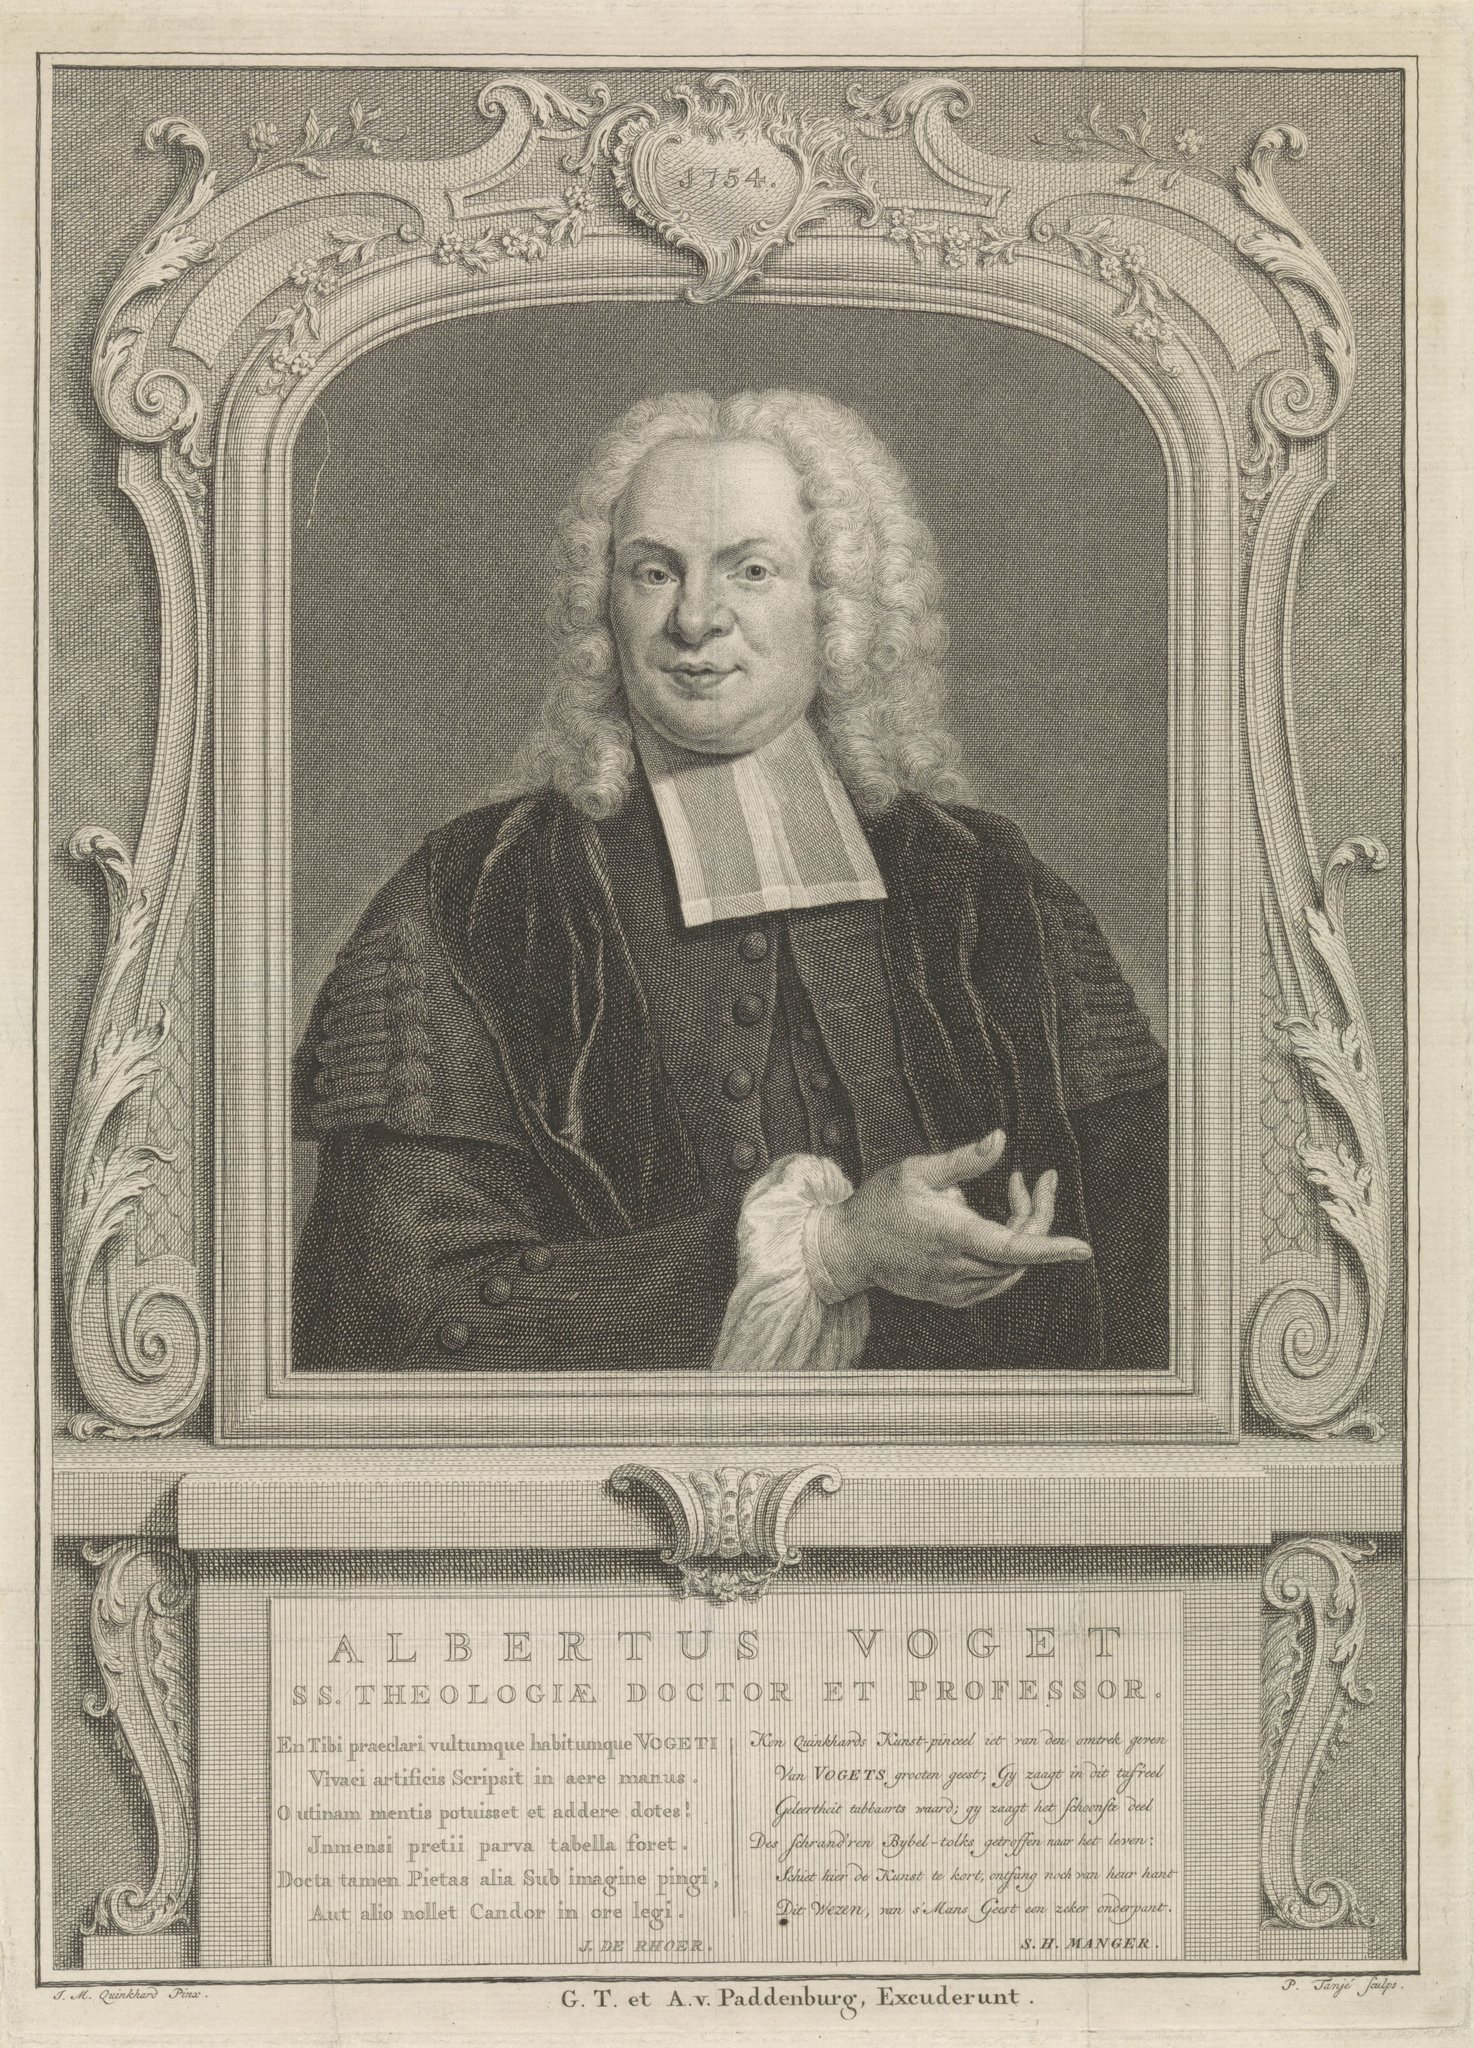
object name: print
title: Portret van Albertus Voget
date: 1716-1761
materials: paper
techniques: engraving, etching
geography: utrecht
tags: utrecht, albertus voget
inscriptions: collector's mark: Lugt 2228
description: Portret van Albertus Voget, predikant en hoogleraar in de theologie, in een ornamentele lijst. Onder het portret een zesregelig vers in het Latijn en het Nederlands.